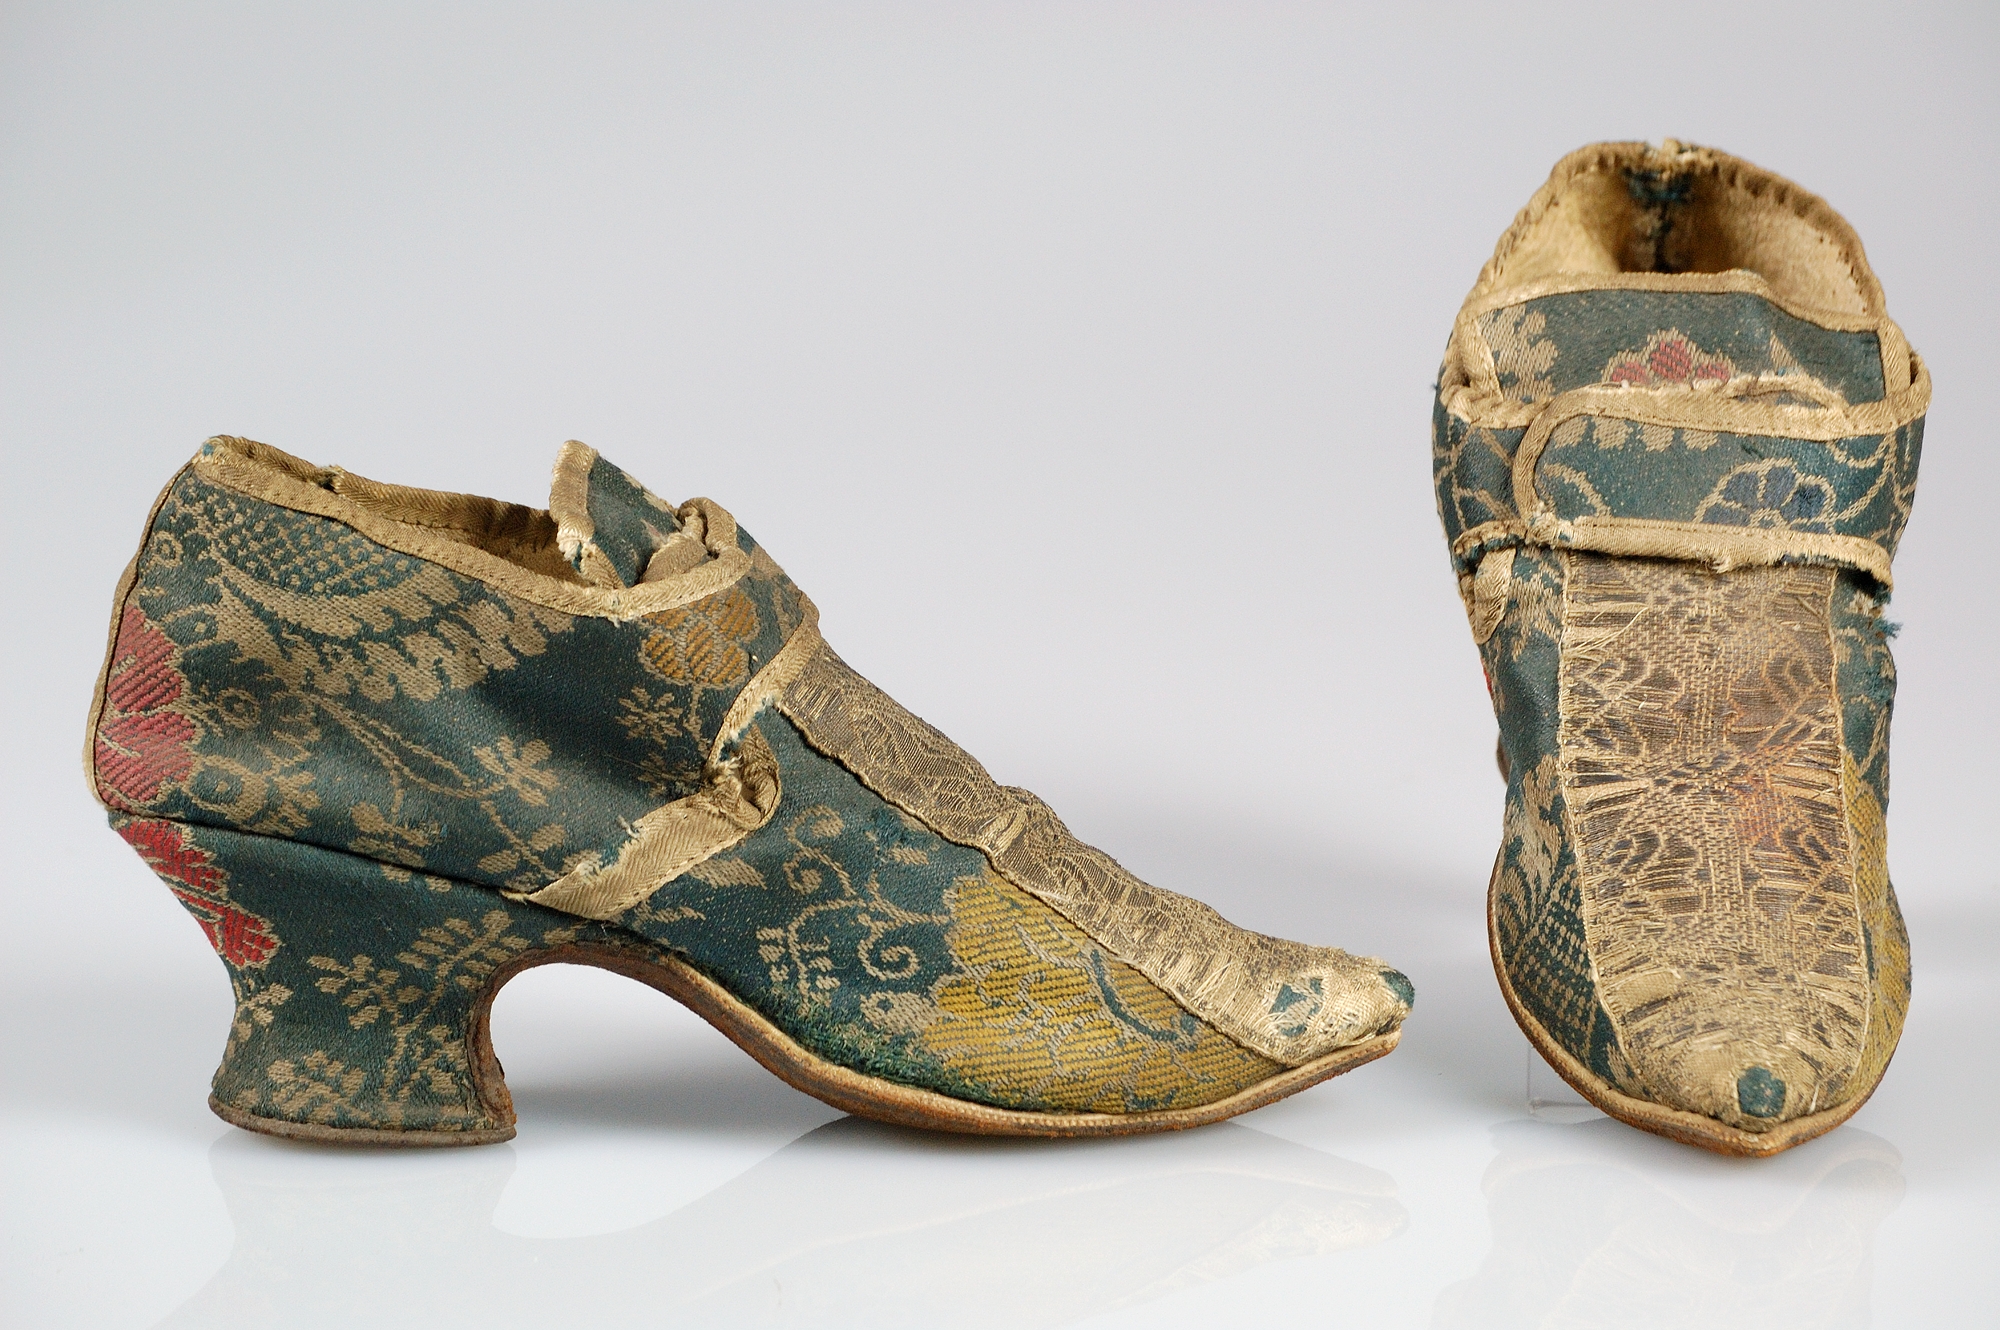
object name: shoe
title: Shoes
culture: european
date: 1720-1739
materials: wool